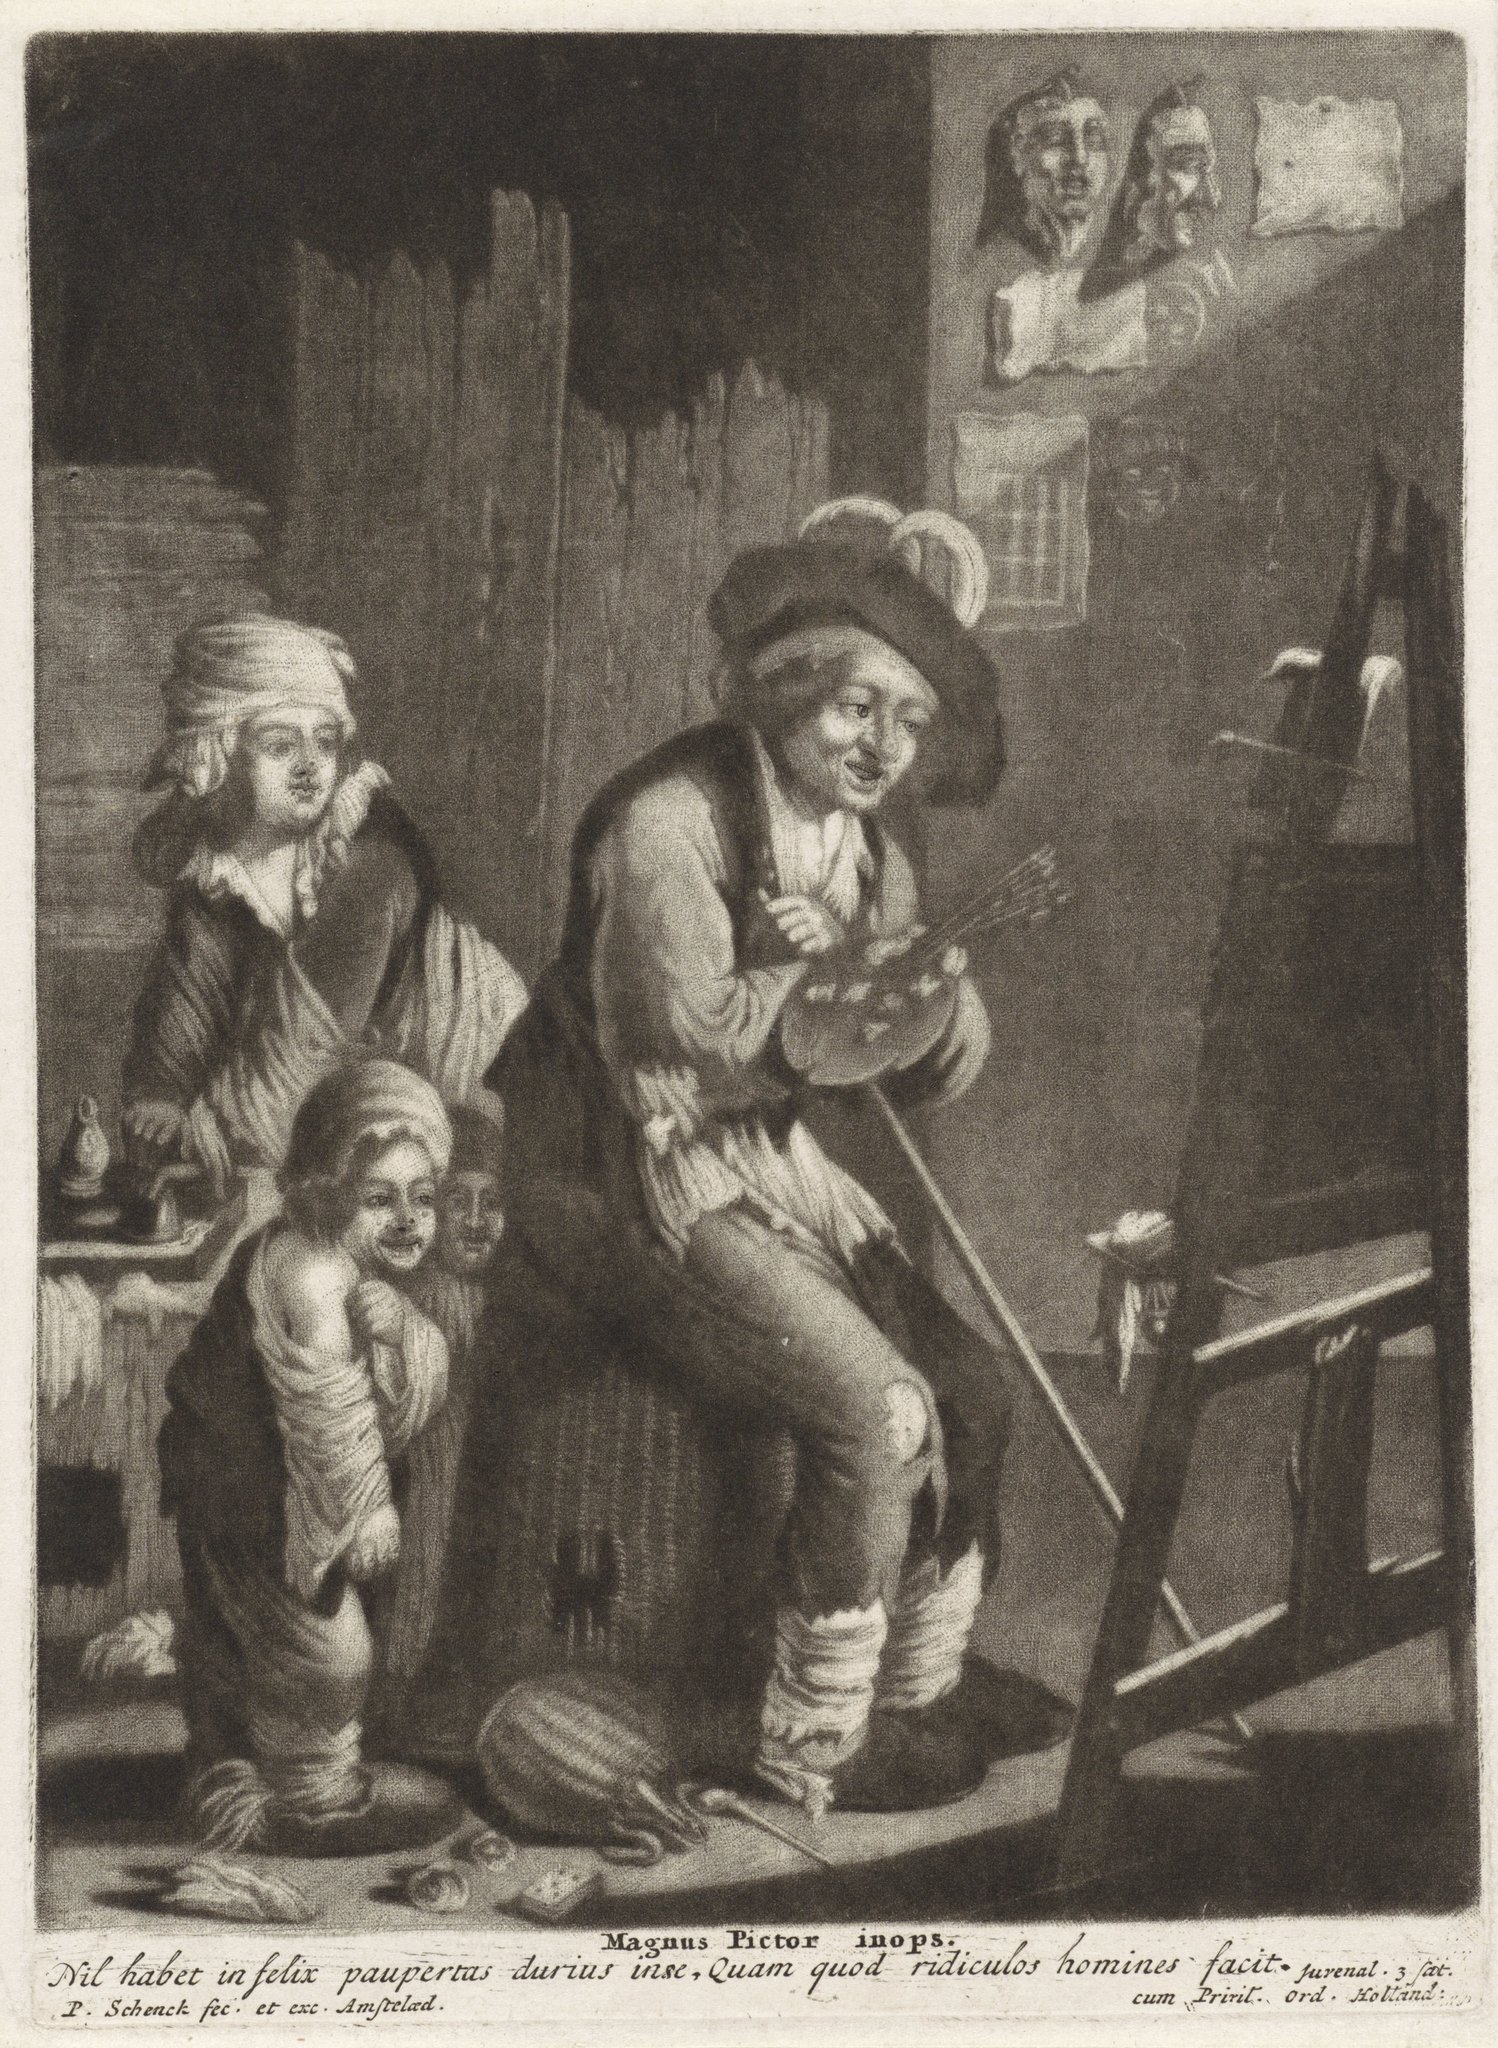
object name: print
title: Arme schilder met zijn familie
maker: pieter schenk (i)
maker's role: print maker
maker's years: 1660-1711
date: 1670-1713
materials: paper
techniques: engraving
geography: amsterdam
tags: tools, implements of painter, painter at work, in his studio, painter in non-work situation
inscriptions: collector's mark: Lugt 2228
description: Een arme schilder en zijn gezin in het atelier. De schilder staat met zijn palet en penselen achter de schildersezel. Aan de muur hangen maskers en vellen papier. Op de grond een omgevallen kruik, een pijpje en een stapel kaarten.